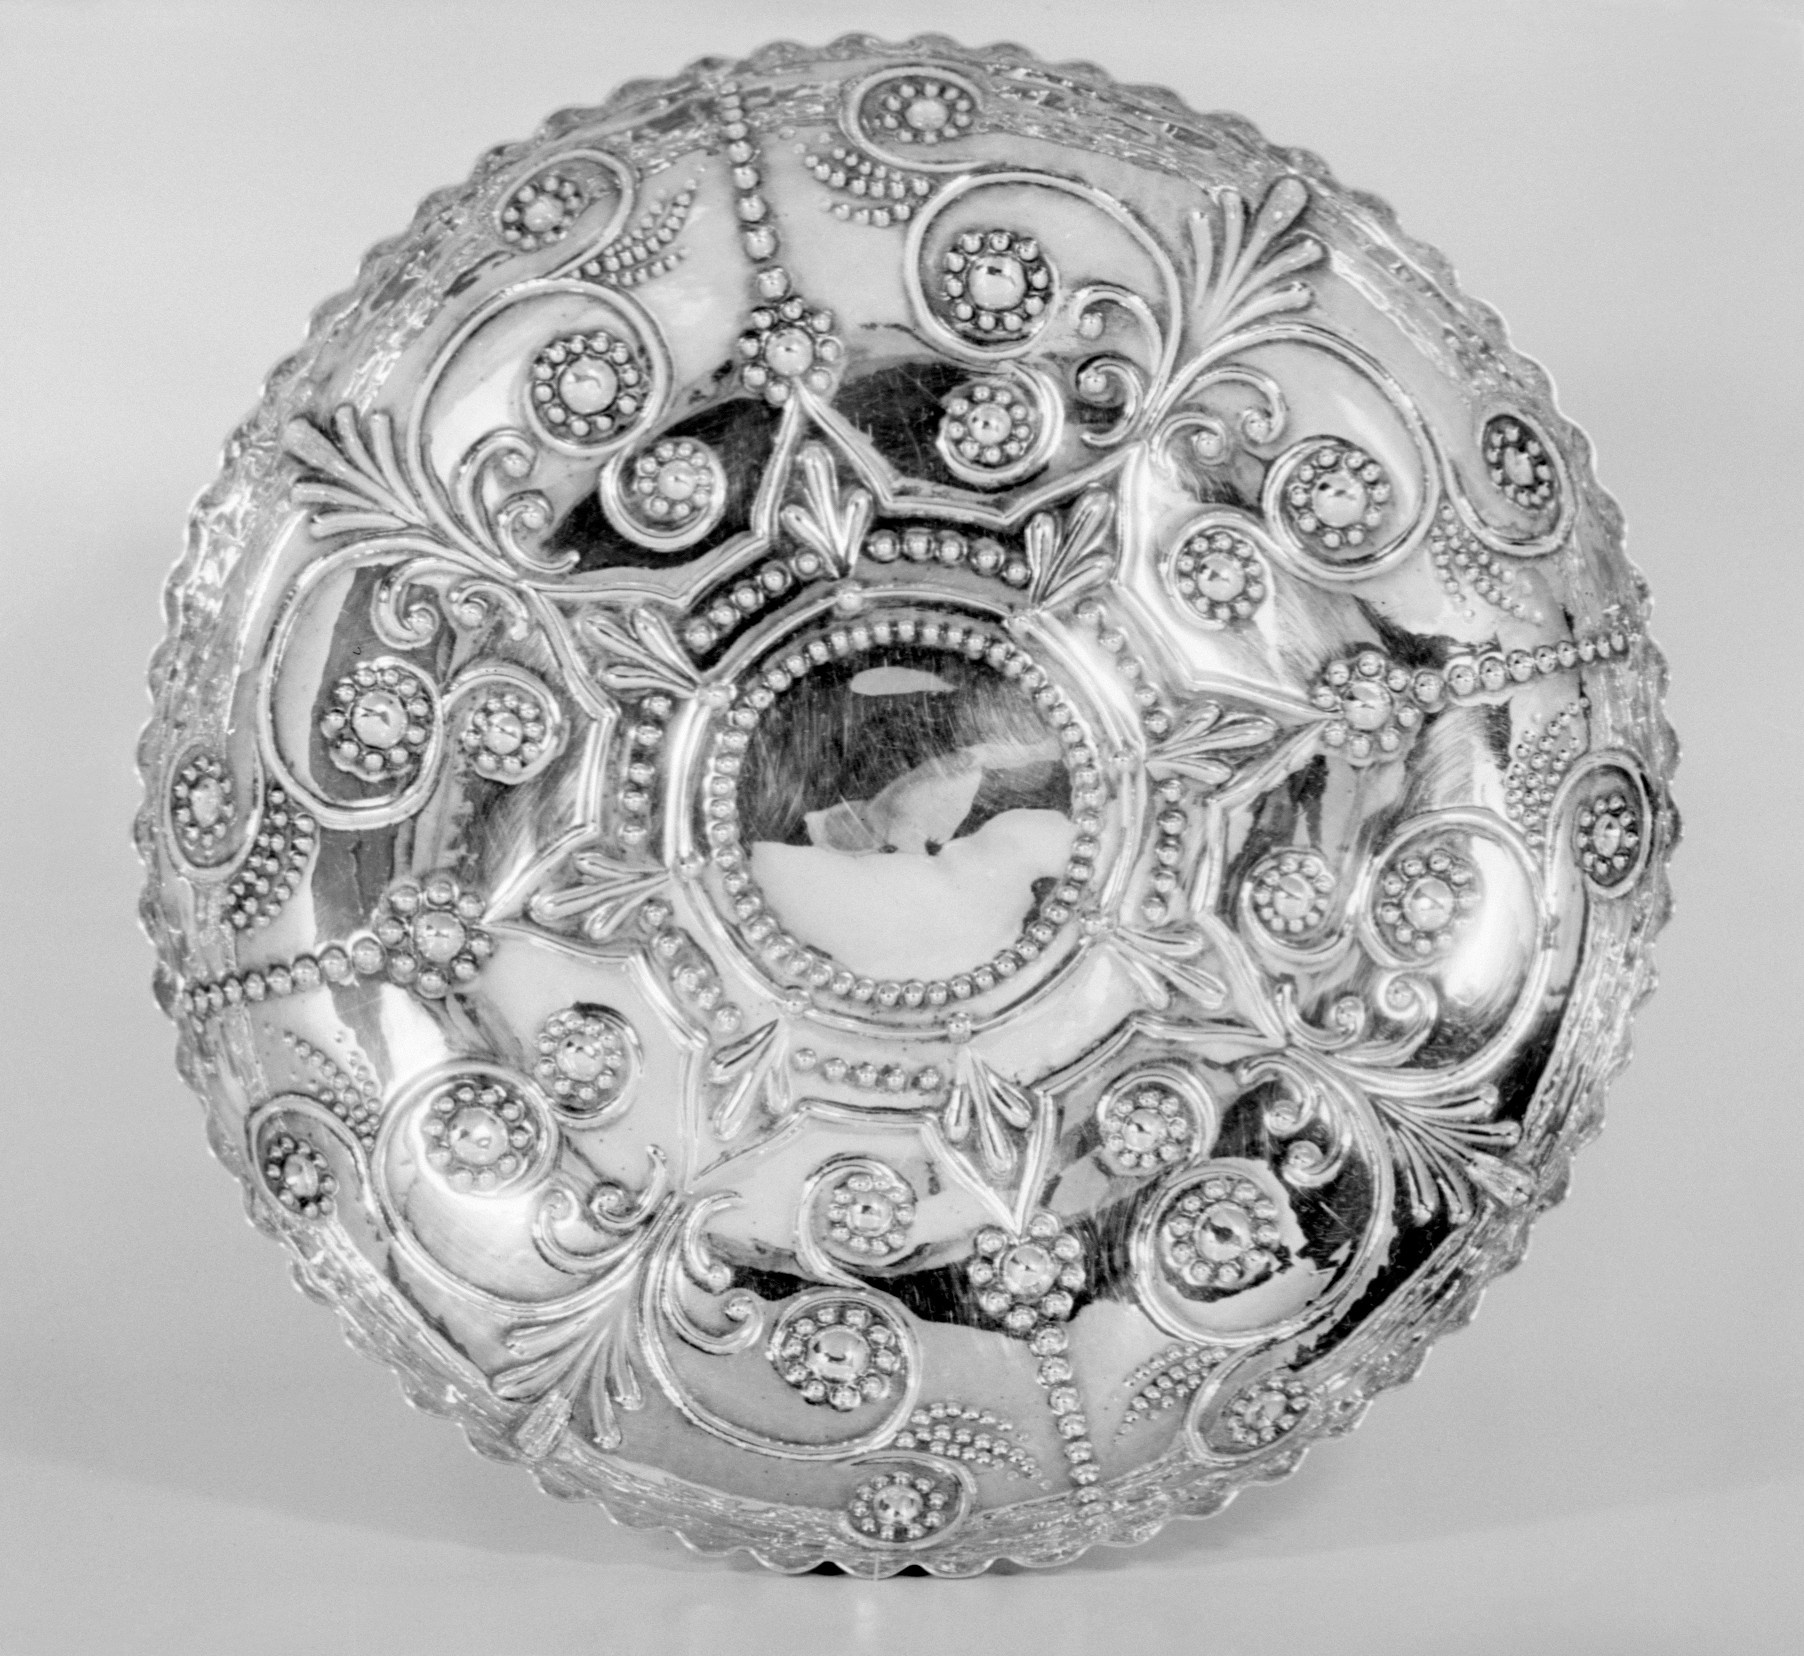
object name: dish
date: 1735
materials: silver